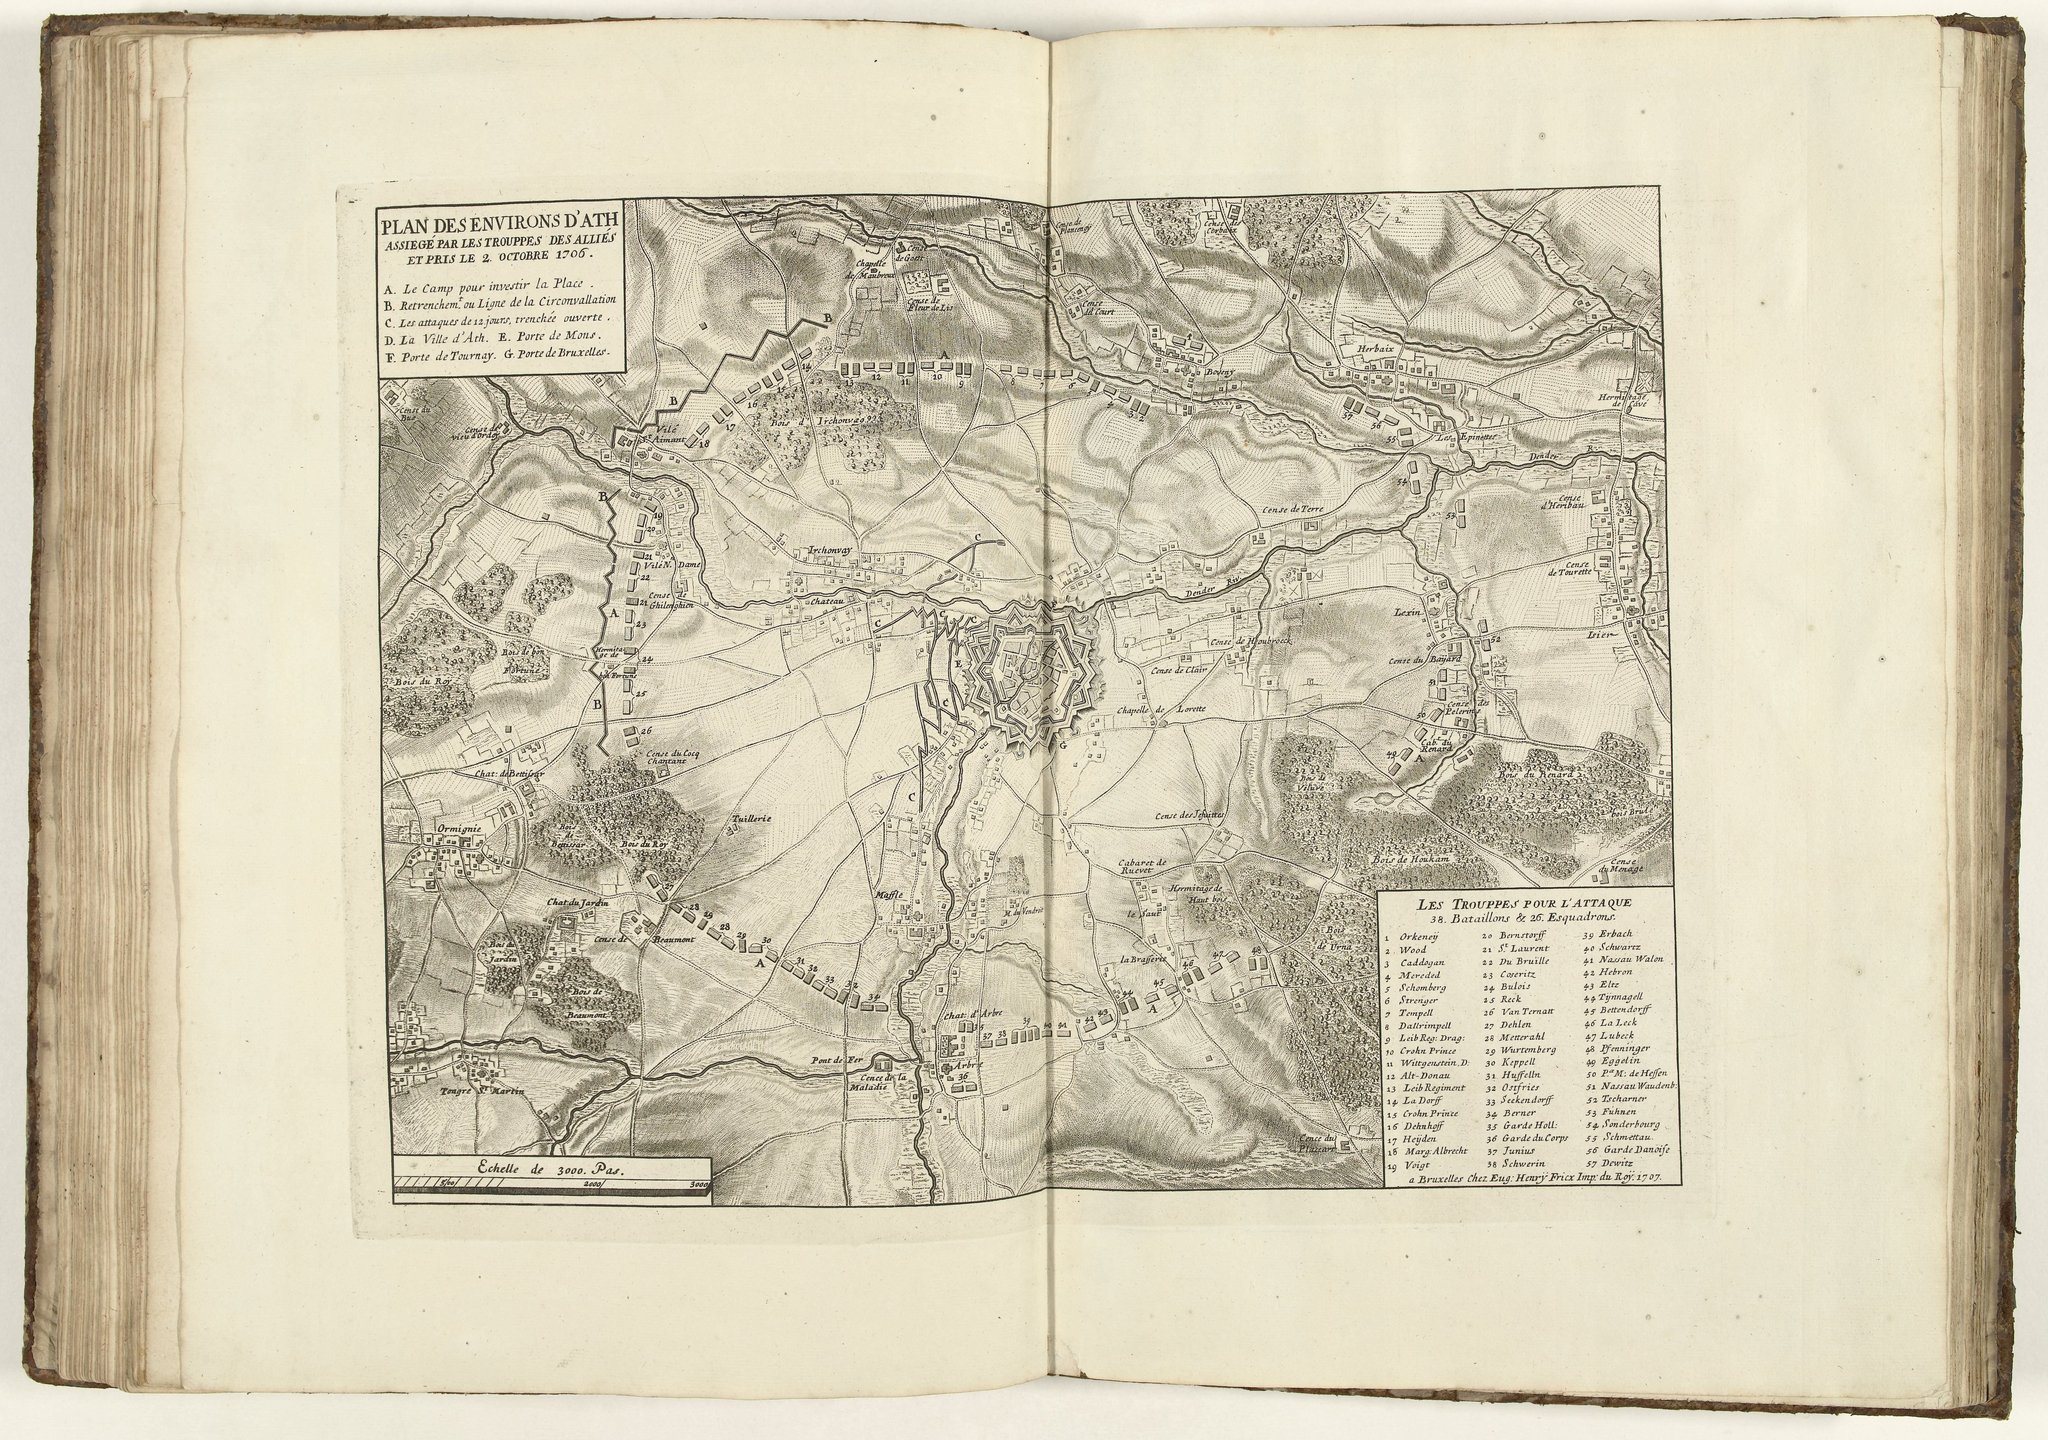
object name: map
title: Plan des environs d'Ath assiegé par les trouppes des alliés et pris le 2. octobre 1706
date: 1707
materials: paper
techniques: engraving, etching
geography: brussels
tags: maps of separate countries or regions, siege, position war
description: Kaart van het beleg van Ath door de Geallieerden, ingenomen op 2 oktober 1706. Rechtsonder een cartouche met een lijst van de Geallieerde regimenten die deel namen aan de belegering. Onderdeel van een gebundelde verzameling van plannen van veldslagen en steden vermaard in de Spaanse Successieoorlog.